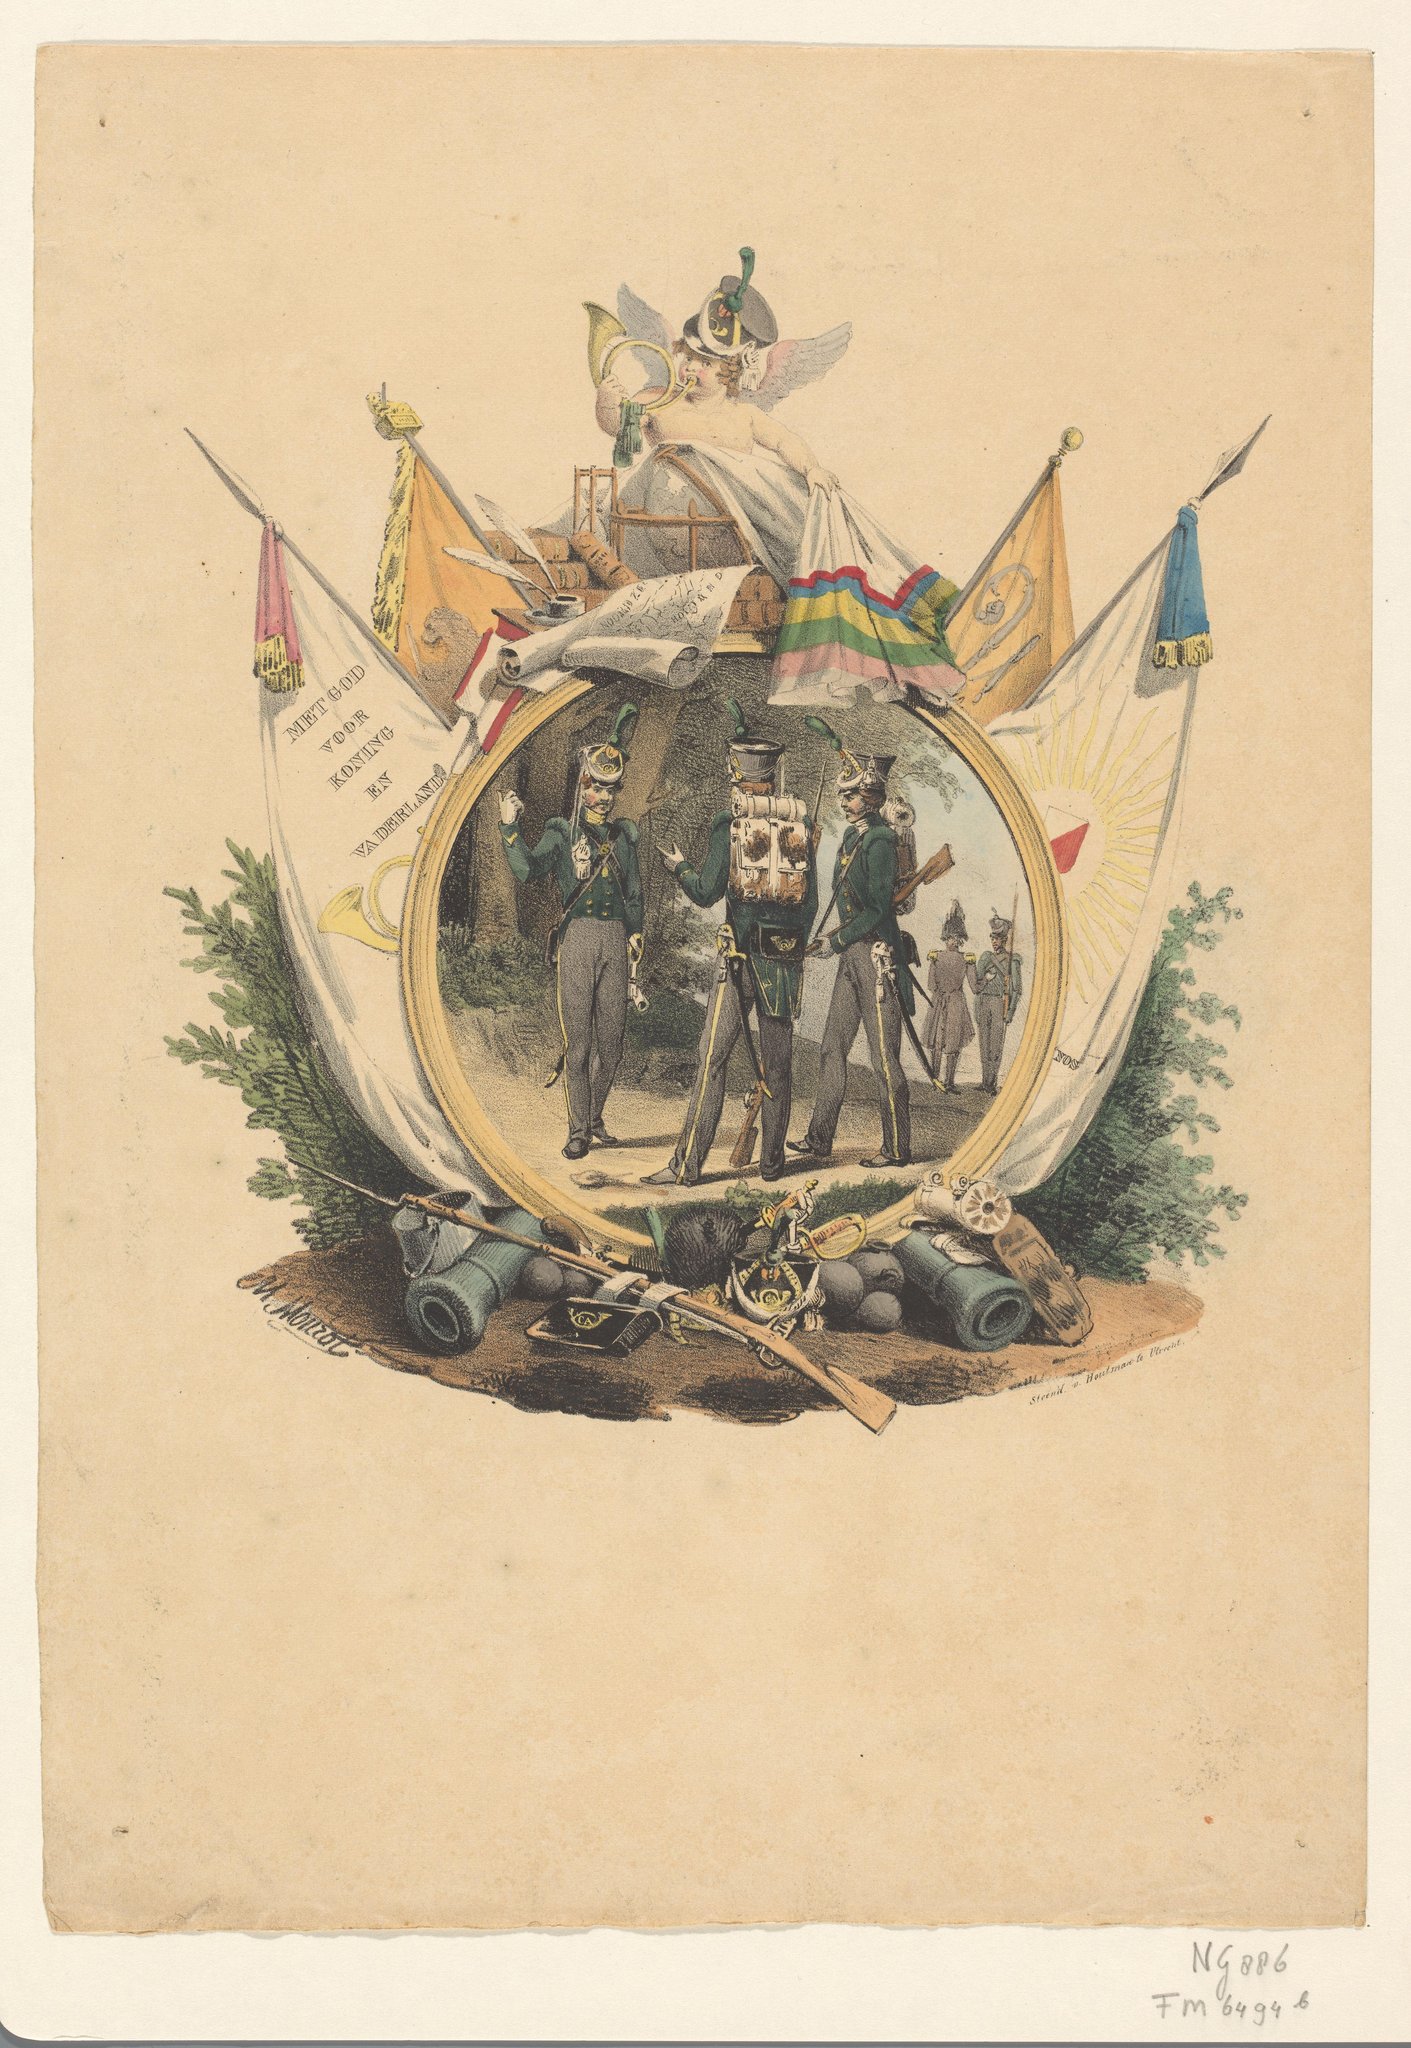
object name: costume print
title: Medaillon met Vrijwillige Jagers der Utrechtse Hogeschool, 1830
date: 1830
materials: paper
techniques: hand coloring, lithograph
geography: utrecht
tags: (military) uniforms (+ infantry), clothes, costume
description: Allegorisch medaillon met een voorstelling van enkele Vrijwillige Jagers der Utrechtse Hogeschool, 1830. Op de grond voor het medaillon liggen wapens en delen van de wapenrusting. Aan weerszijden vaandels, rechts een vaandel met het stadswapen van Utrecht. Bovenaan attributen van de universitaire studie: boeken, pen en papier, met een putto met helm die op een hoorn blaast. Zie ook de pendant.